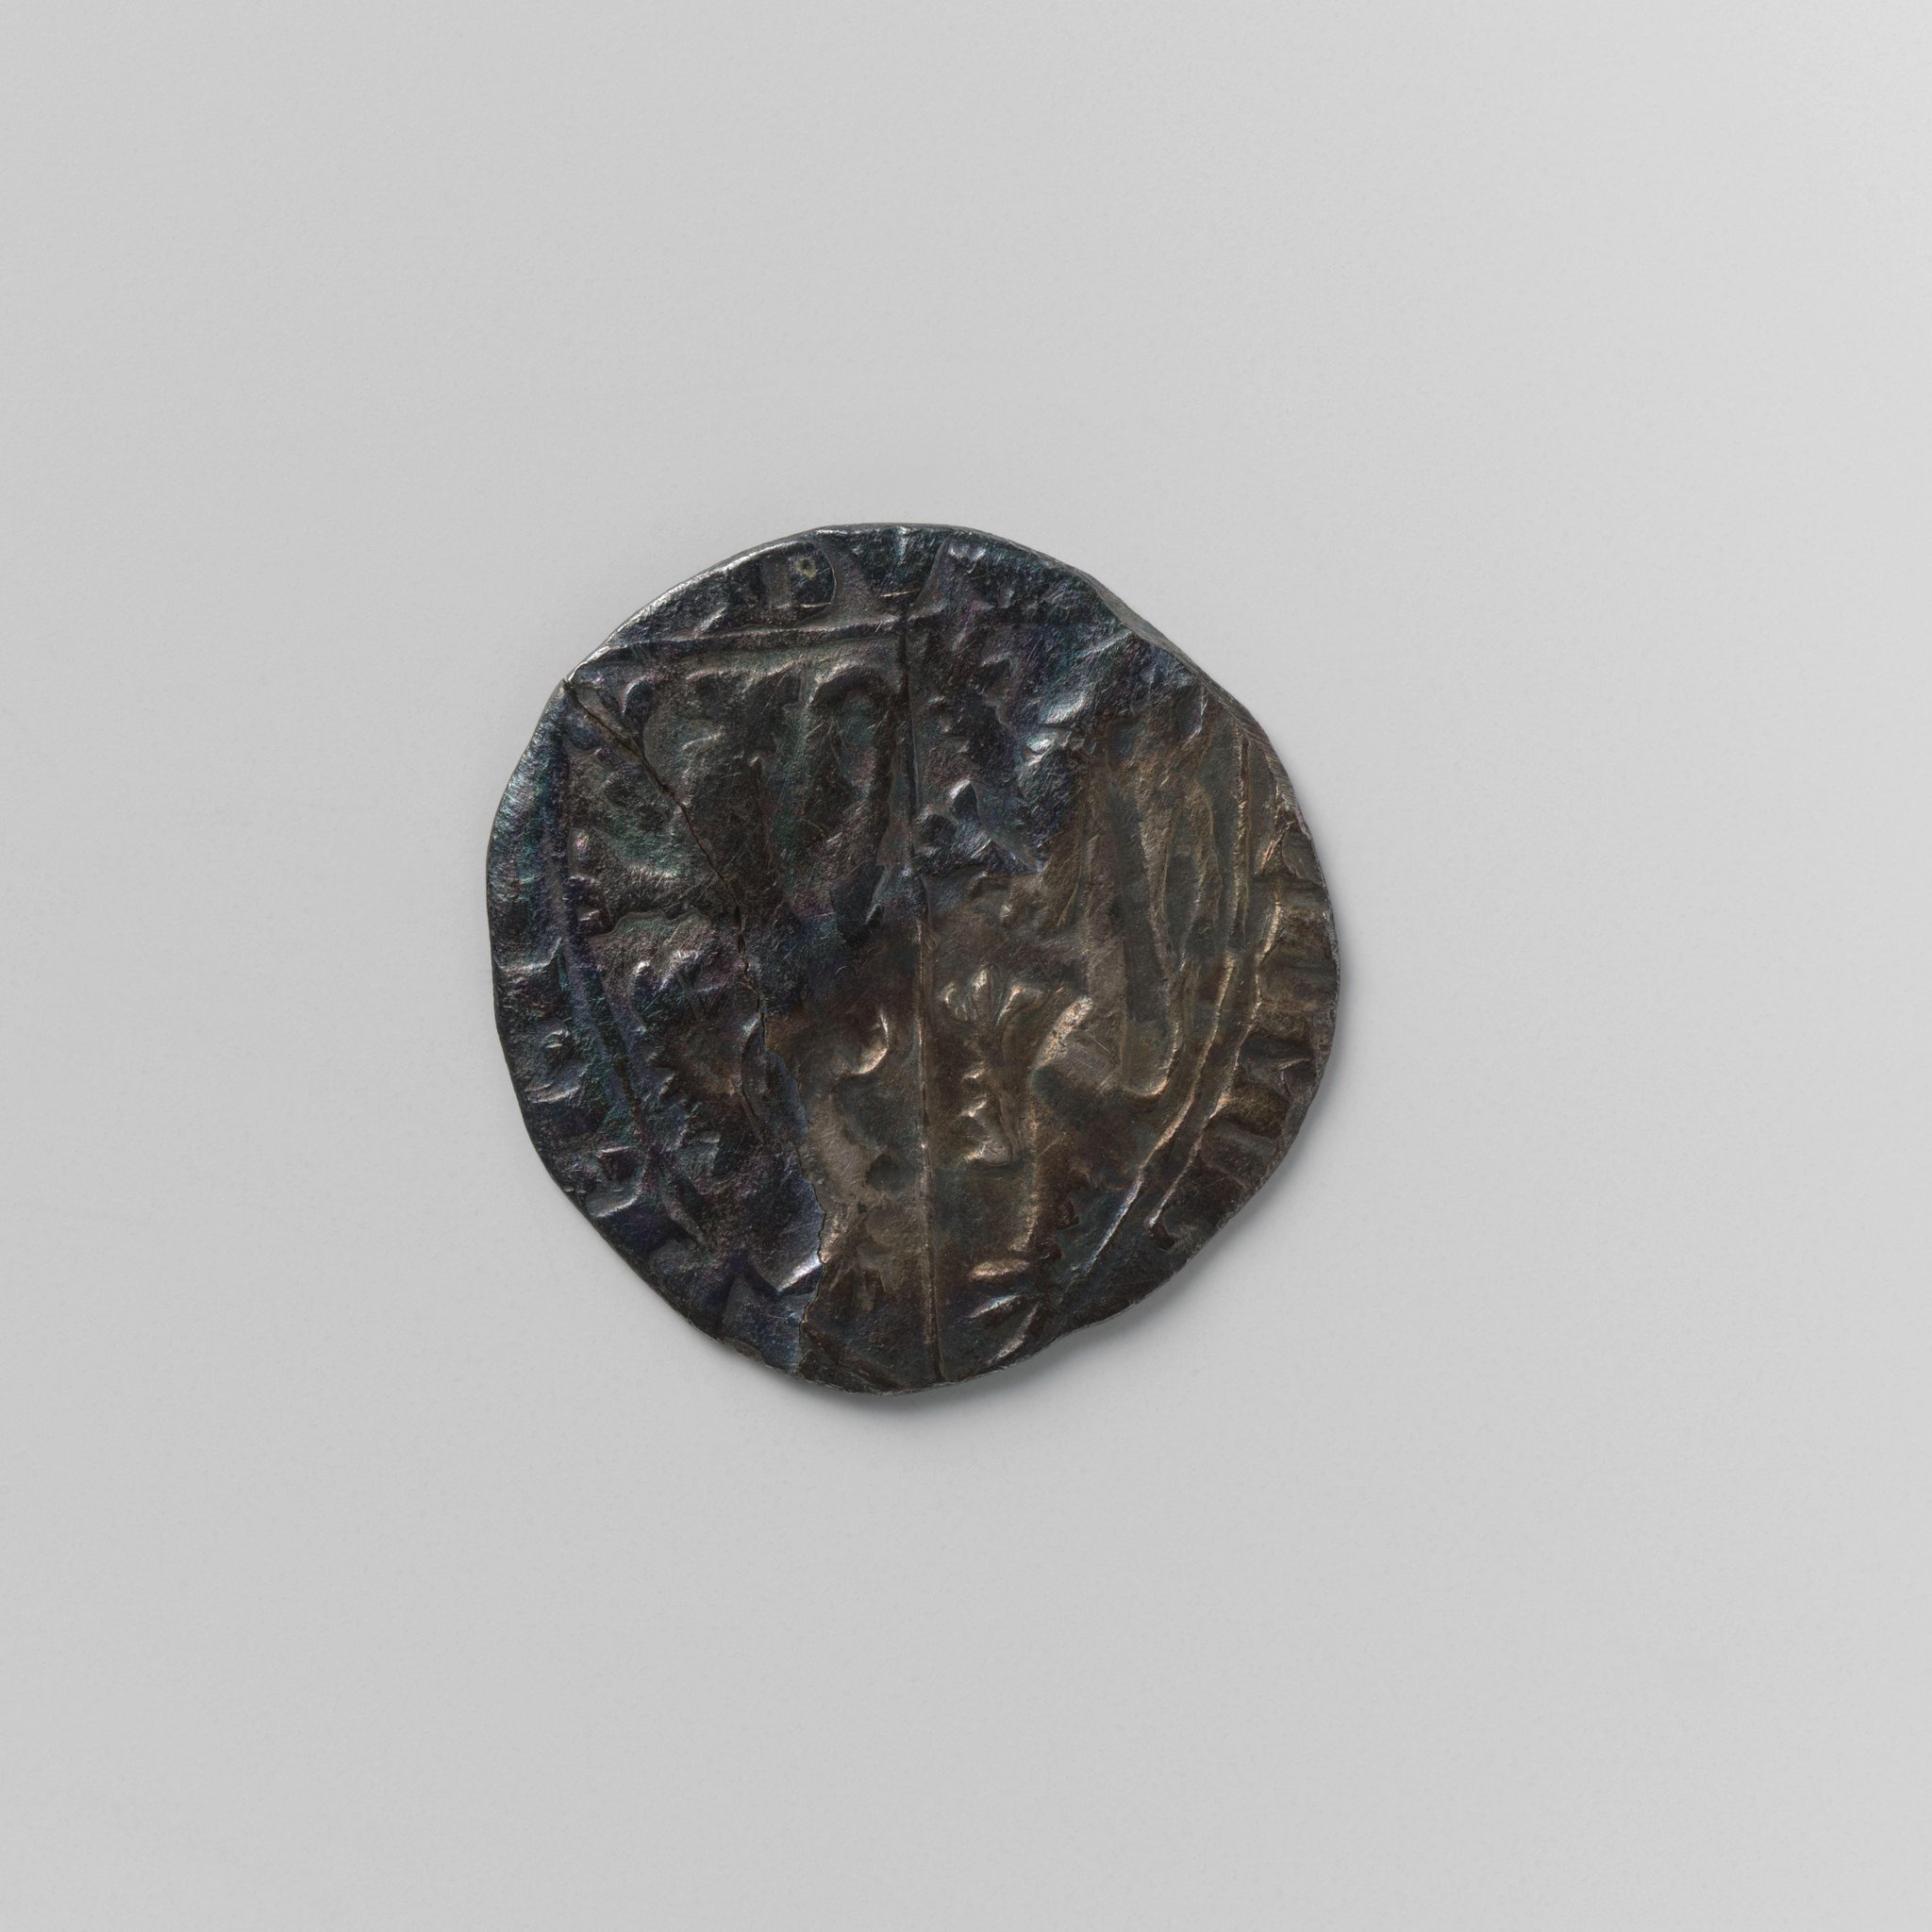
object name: coin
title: Sterling uit Brabant van Jan I, 1268-1294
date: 1288-1294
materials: silver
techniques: striking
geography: bonn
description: Voorzijde: in een punt uitlopend gecombineerd Brabants/Limburgs wapenschild, waaromheen omschrift DVX-LIMB-VRGIE . Keerzijde: lang kruis, in de hoeken klaverblaadjes. Daaromheen omschrift DVX-BRA-BAN-TIE. Geslagen te Bonn.